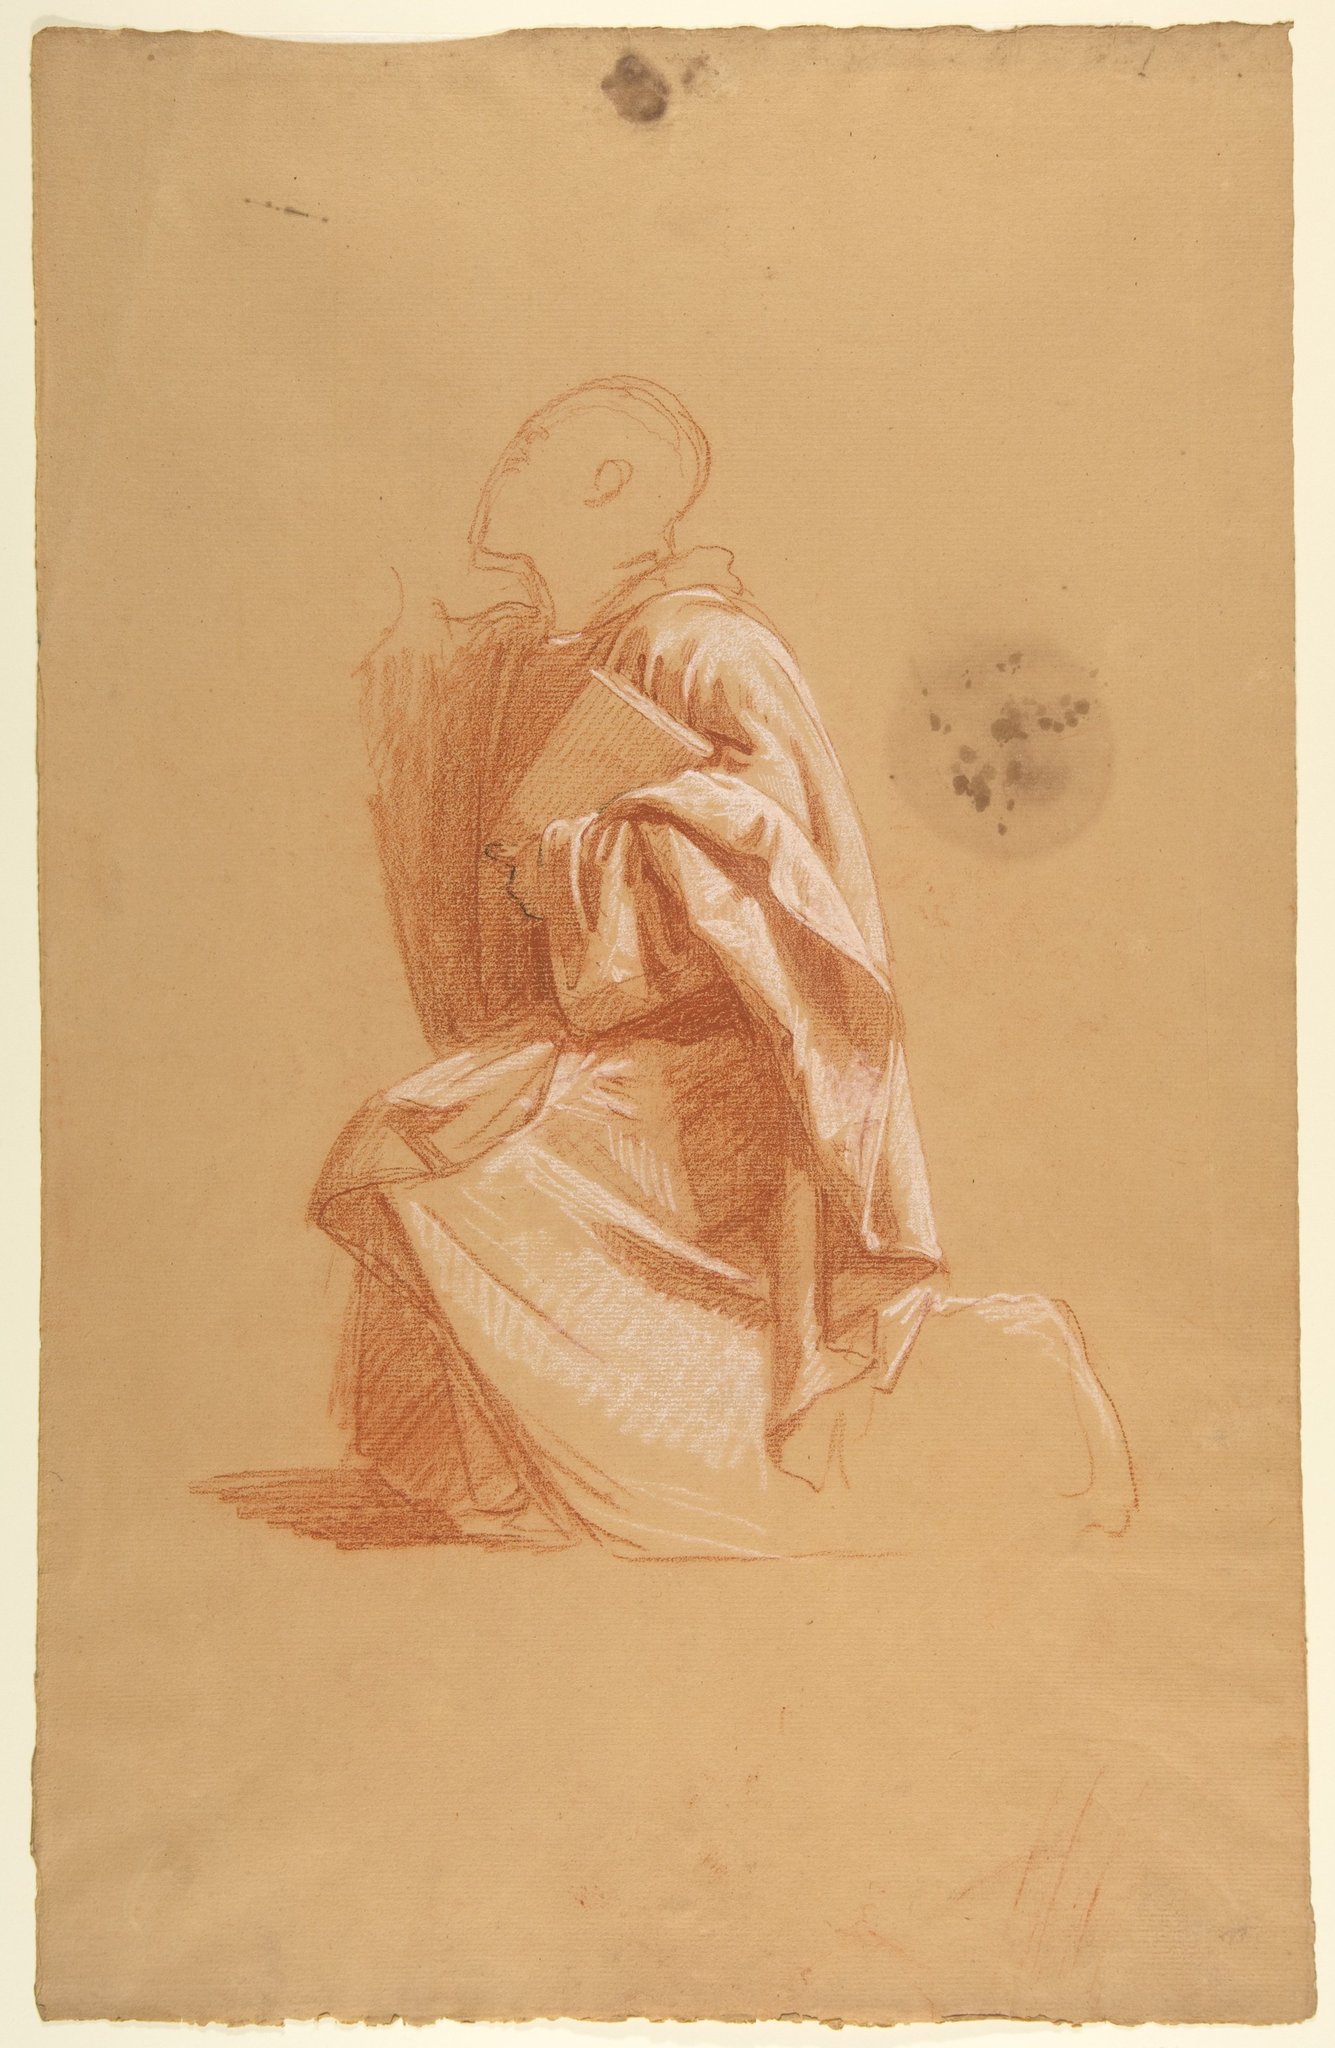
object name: drawing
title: Cleric (lower register; study for wall paintings in the Chapel of Saint Remi, Sainte-Clotilde, Paris, 1858)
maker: isidore pils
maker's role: artist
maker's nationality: french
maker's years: 1813-1875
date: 1801-1900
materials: chalk, paper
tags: men